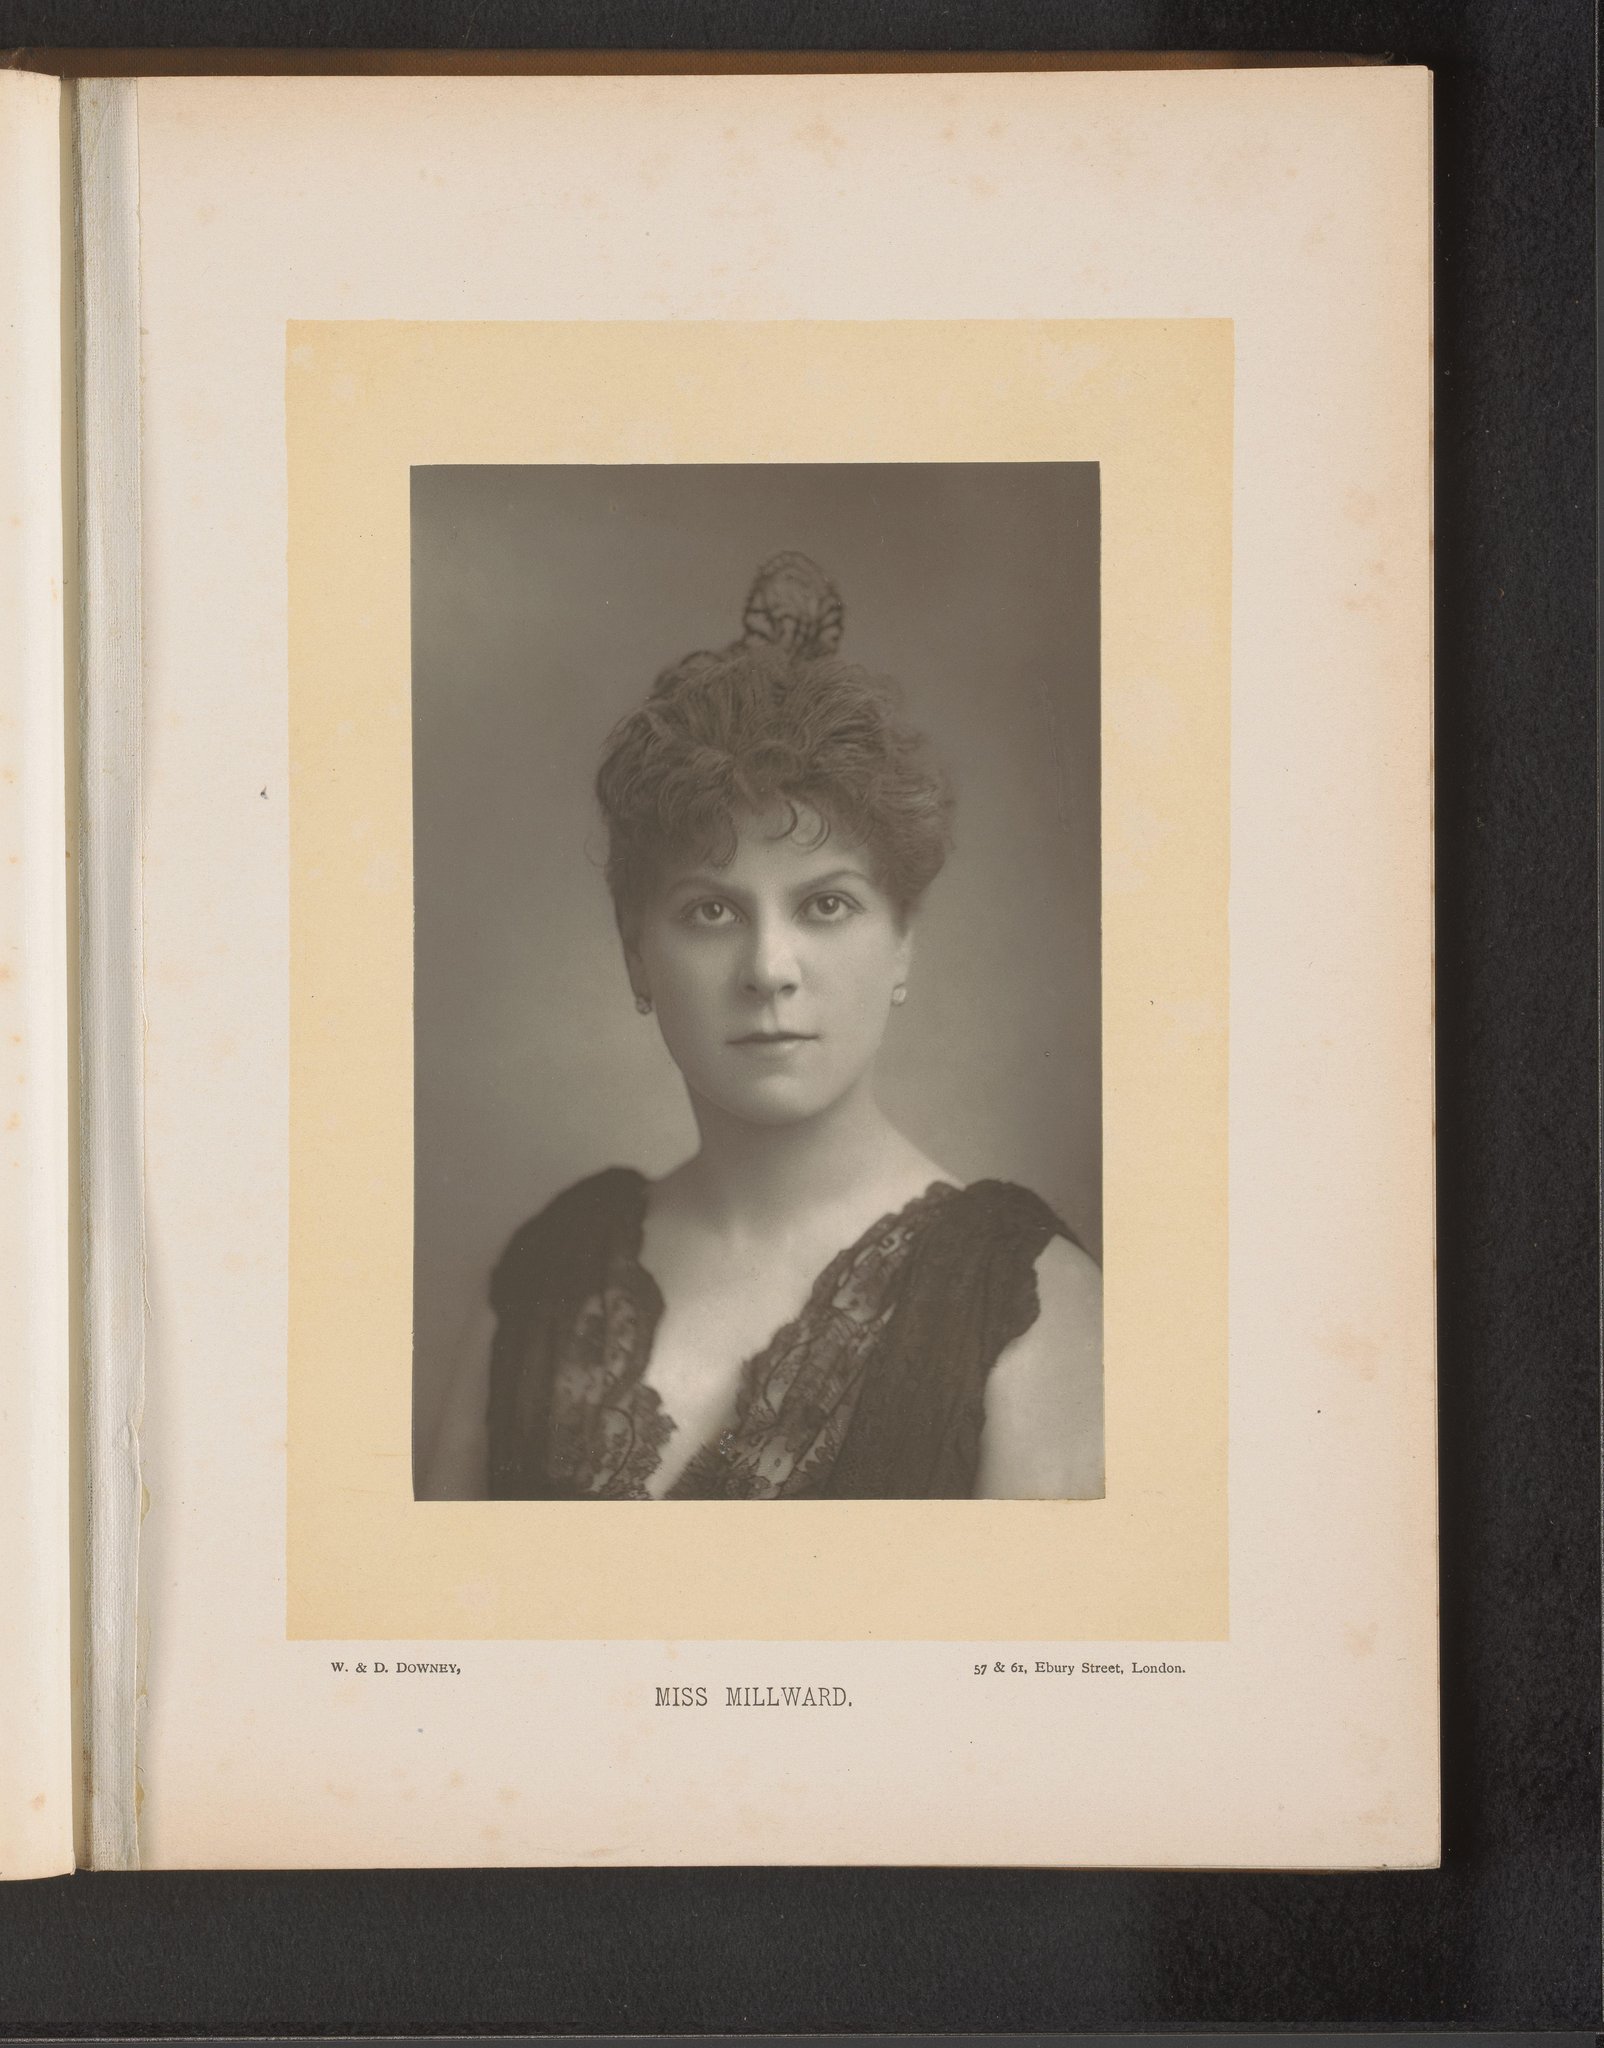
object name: page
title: Portret van Jessie Millward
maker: Anonymous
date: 1884-1894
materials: paper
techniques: woodburytype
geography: london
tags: portrait of actor, actress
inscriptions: inscription: ‘57 & 61, Elbury Street, London.’